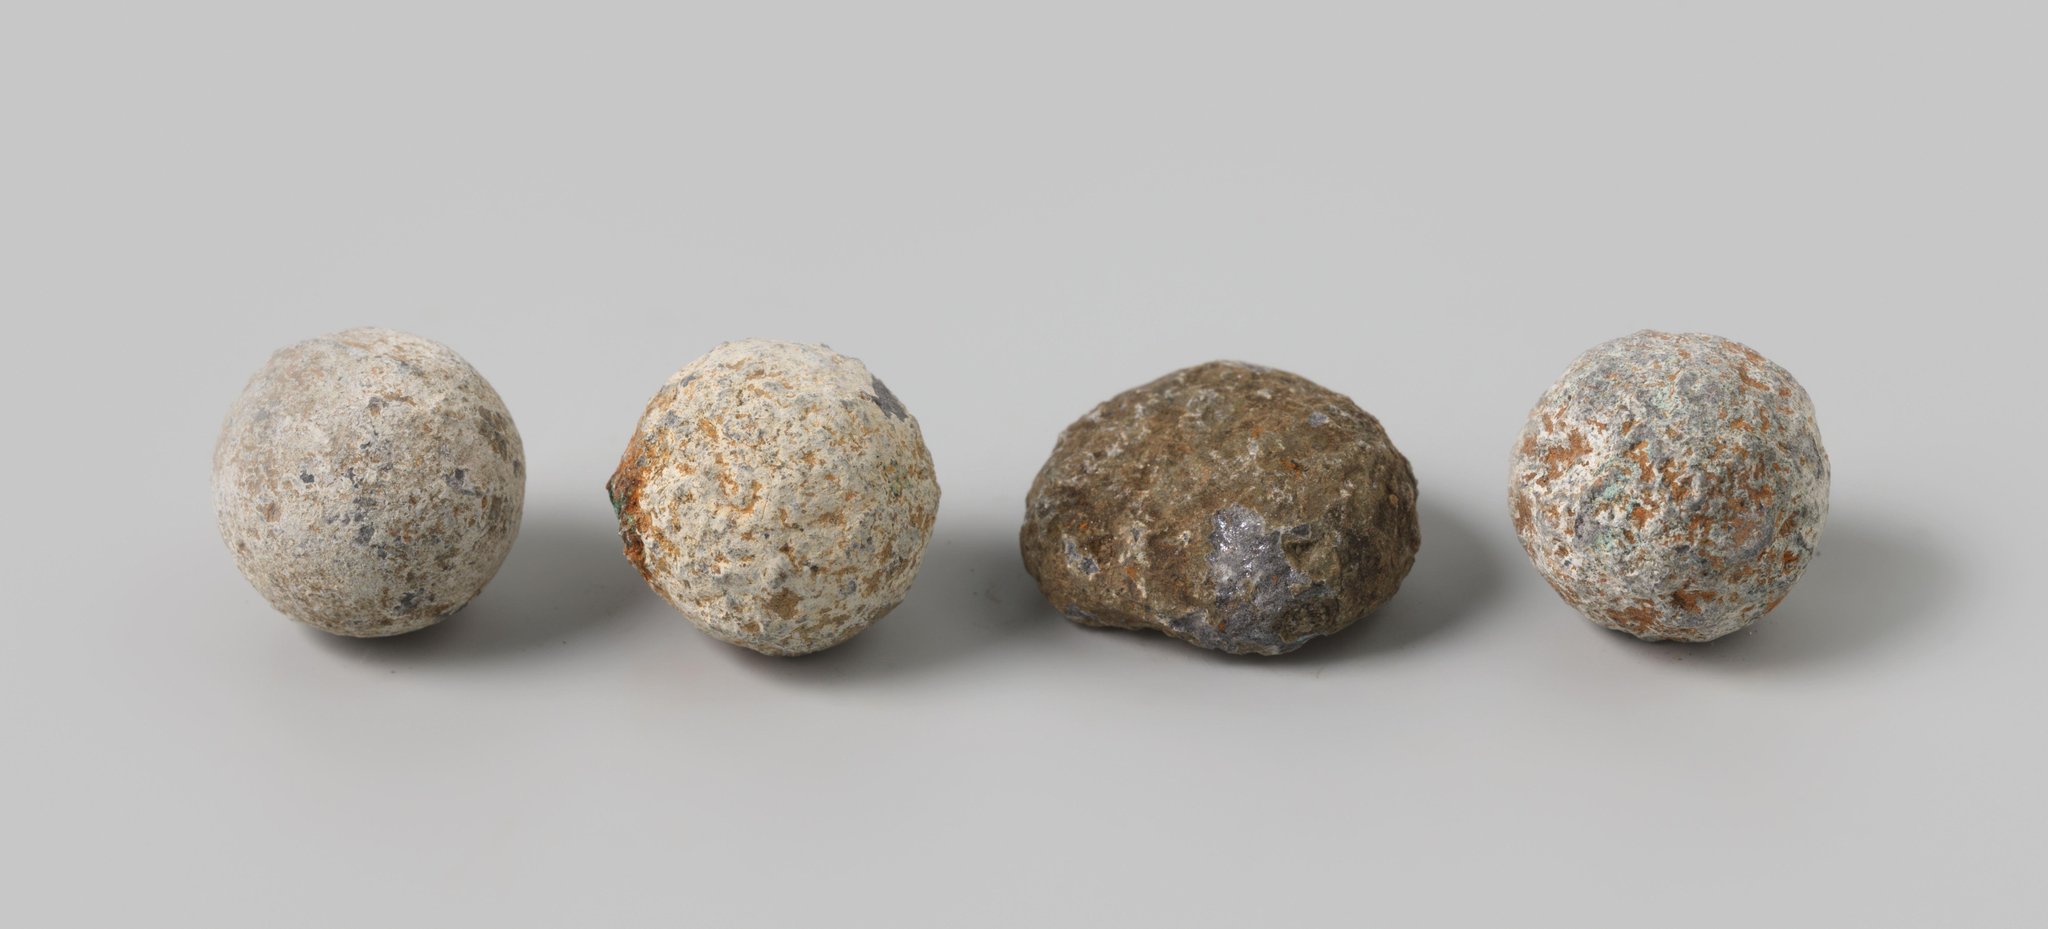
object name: musketkogel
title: Musketkogels uit het wrak van de Oost-Indiëvaarder Hollandia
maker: Anonymous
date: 1700-1743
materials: lead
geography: netherlands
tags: verenigde oostindische compagnie, hollandia (schip), annet